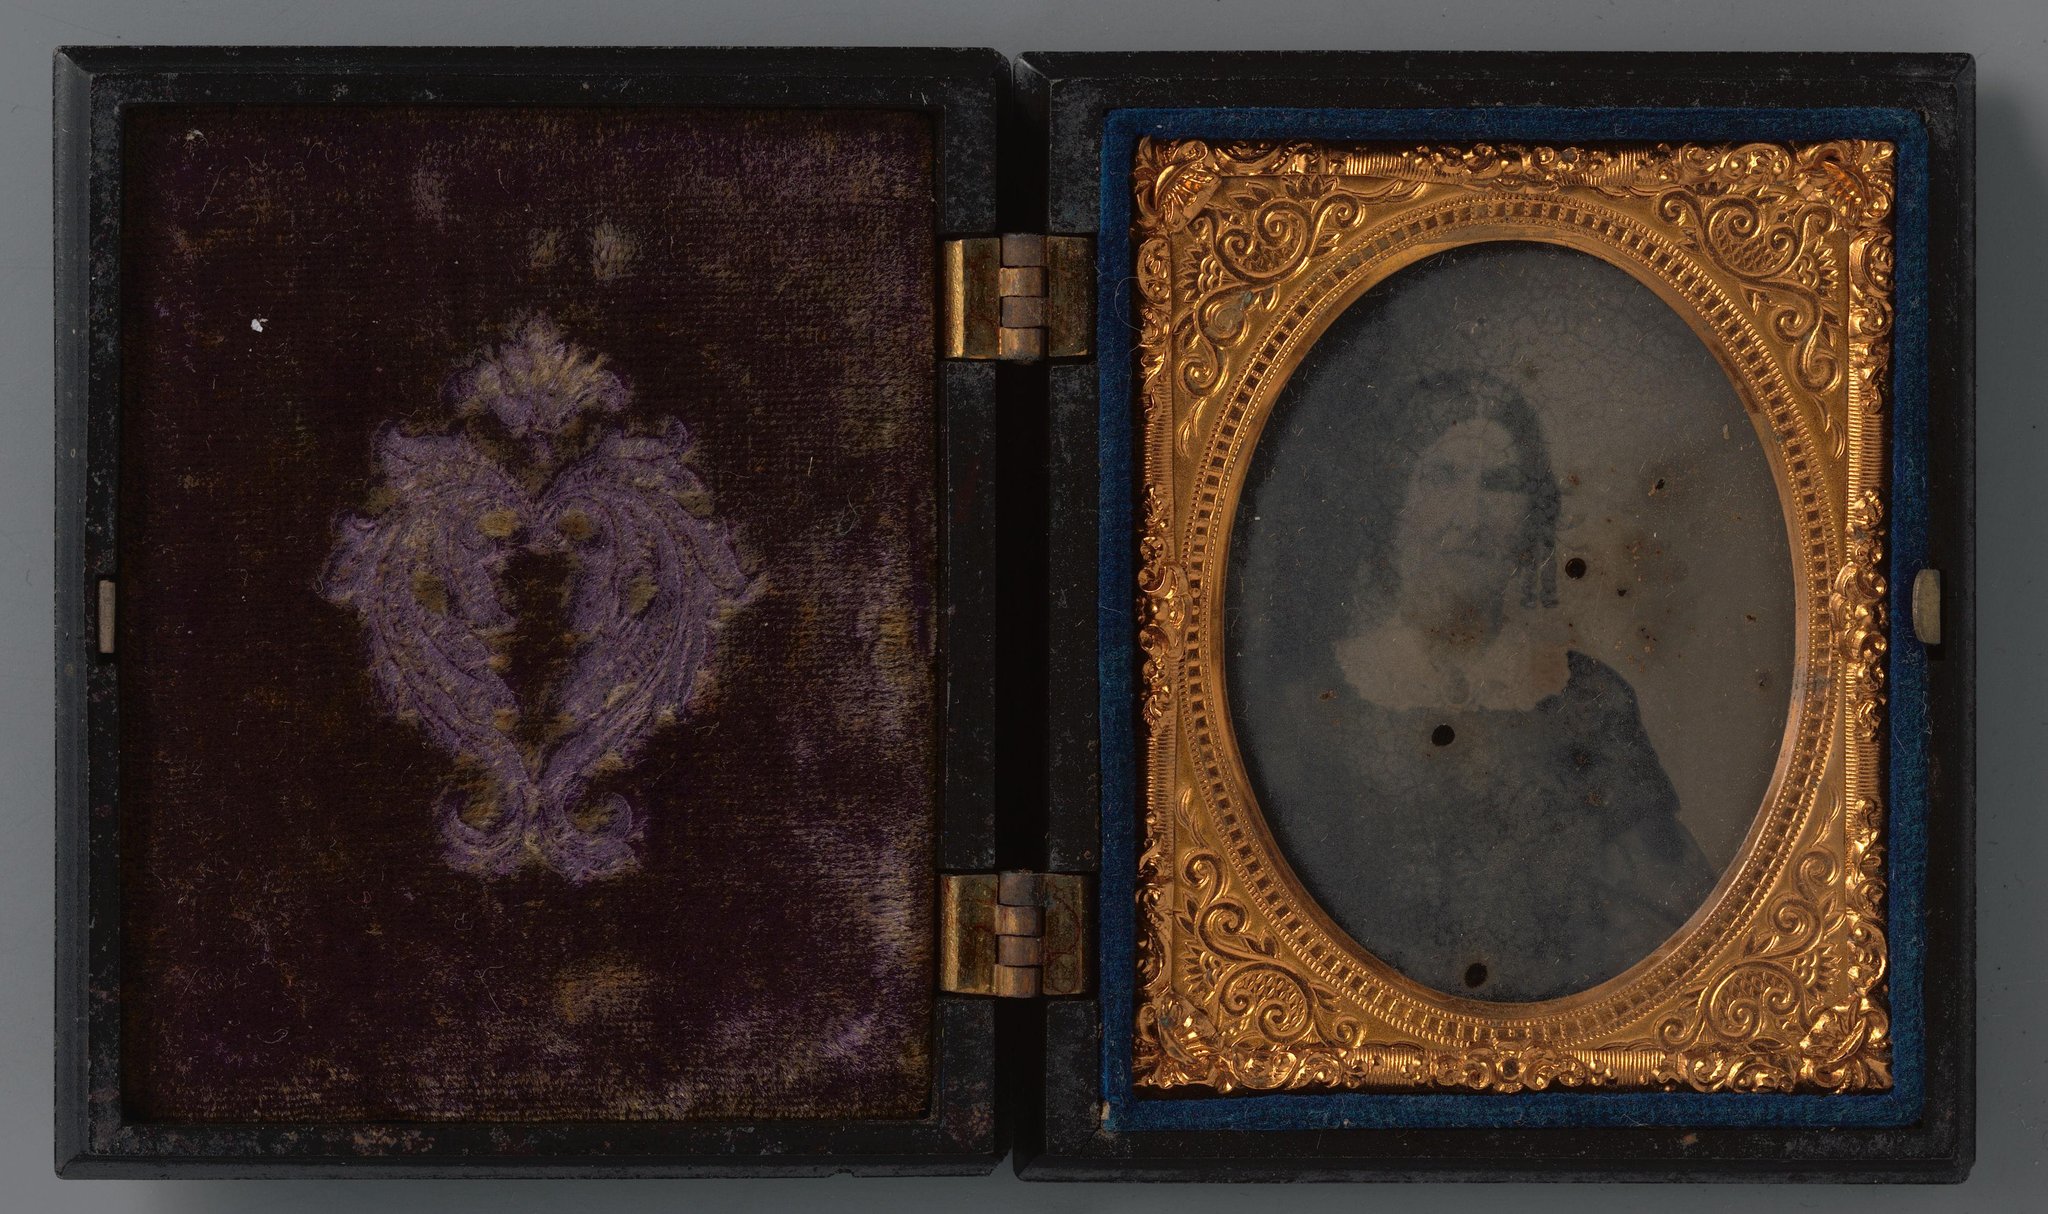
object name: photograph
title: Portret van een onbekende vrouw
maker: Anonymous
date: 1855-1870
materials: glass, metal, velvet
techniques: ambrotype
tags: historical persons - bb - woman